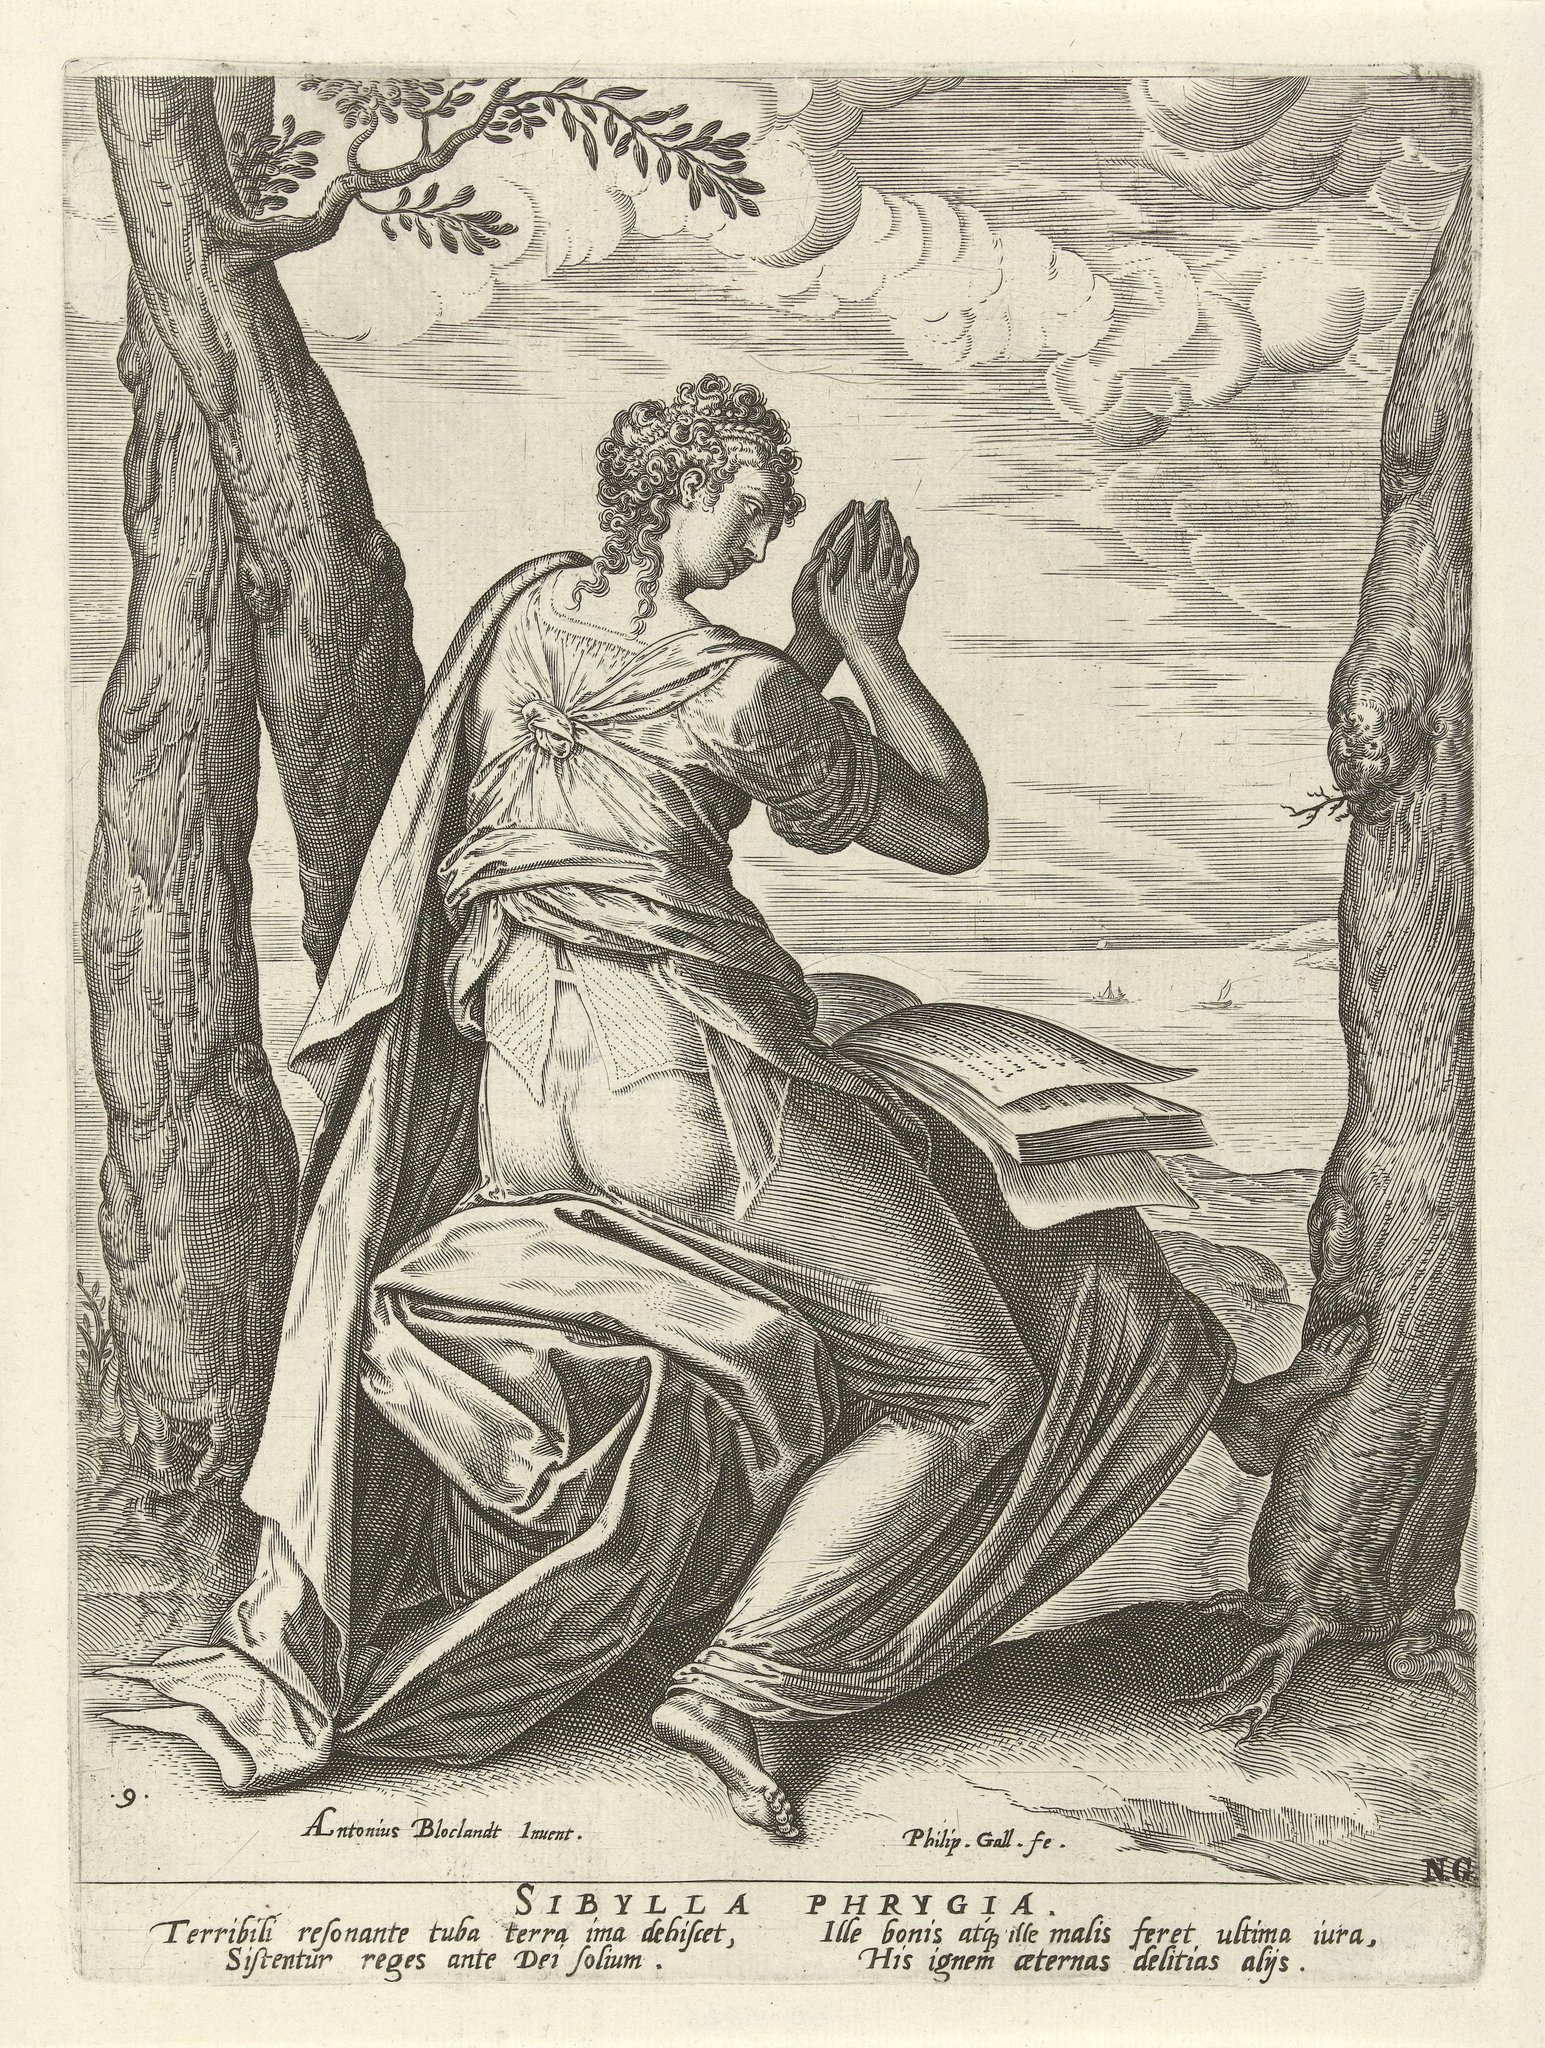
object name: print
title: Frygische Sibylla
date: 1575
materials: paper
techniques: engraving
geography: antwerp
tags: sibyls (with name)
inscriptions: collector's mark: Lugt 2228, collector's mark: Lugt 1967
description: De Frygische Sibille zit op een boomstam. Een boek ligt open op haar knieën.. De prent heeft een Latijns onderschrift en maakt deel uit van een tiendelige serie over de Sibillen.